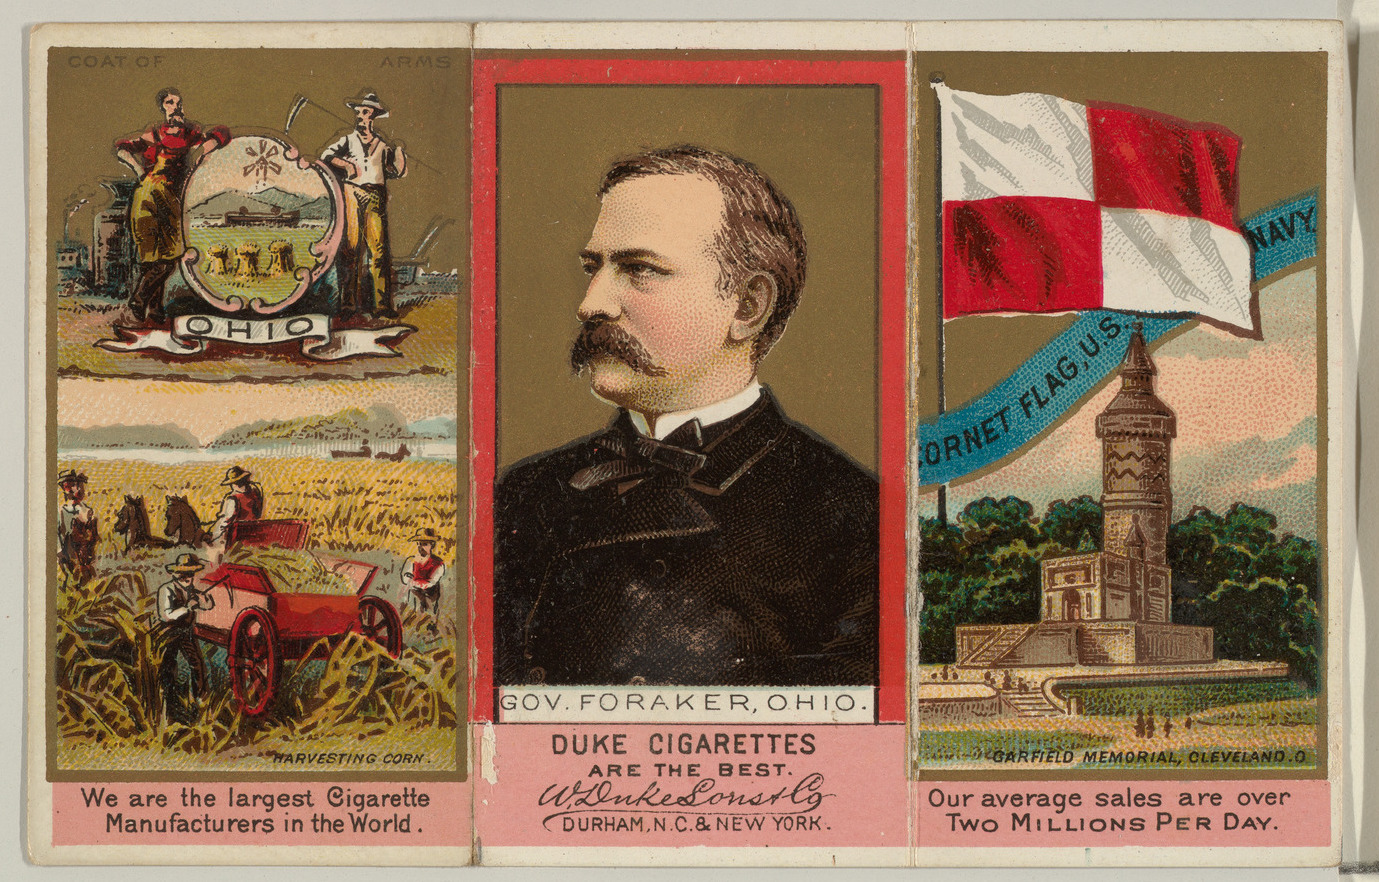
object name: print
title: Governor Foraker, Ohio, from "Governors, Arms, Etc." series (N133-2), issued by Duke Sons & Co.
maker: w. duke, sons & co.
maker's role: publisher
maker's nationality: american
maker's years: 1870-1920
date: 1888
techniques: color lithograph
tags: men,profiles,coat of arms,flags,carriages